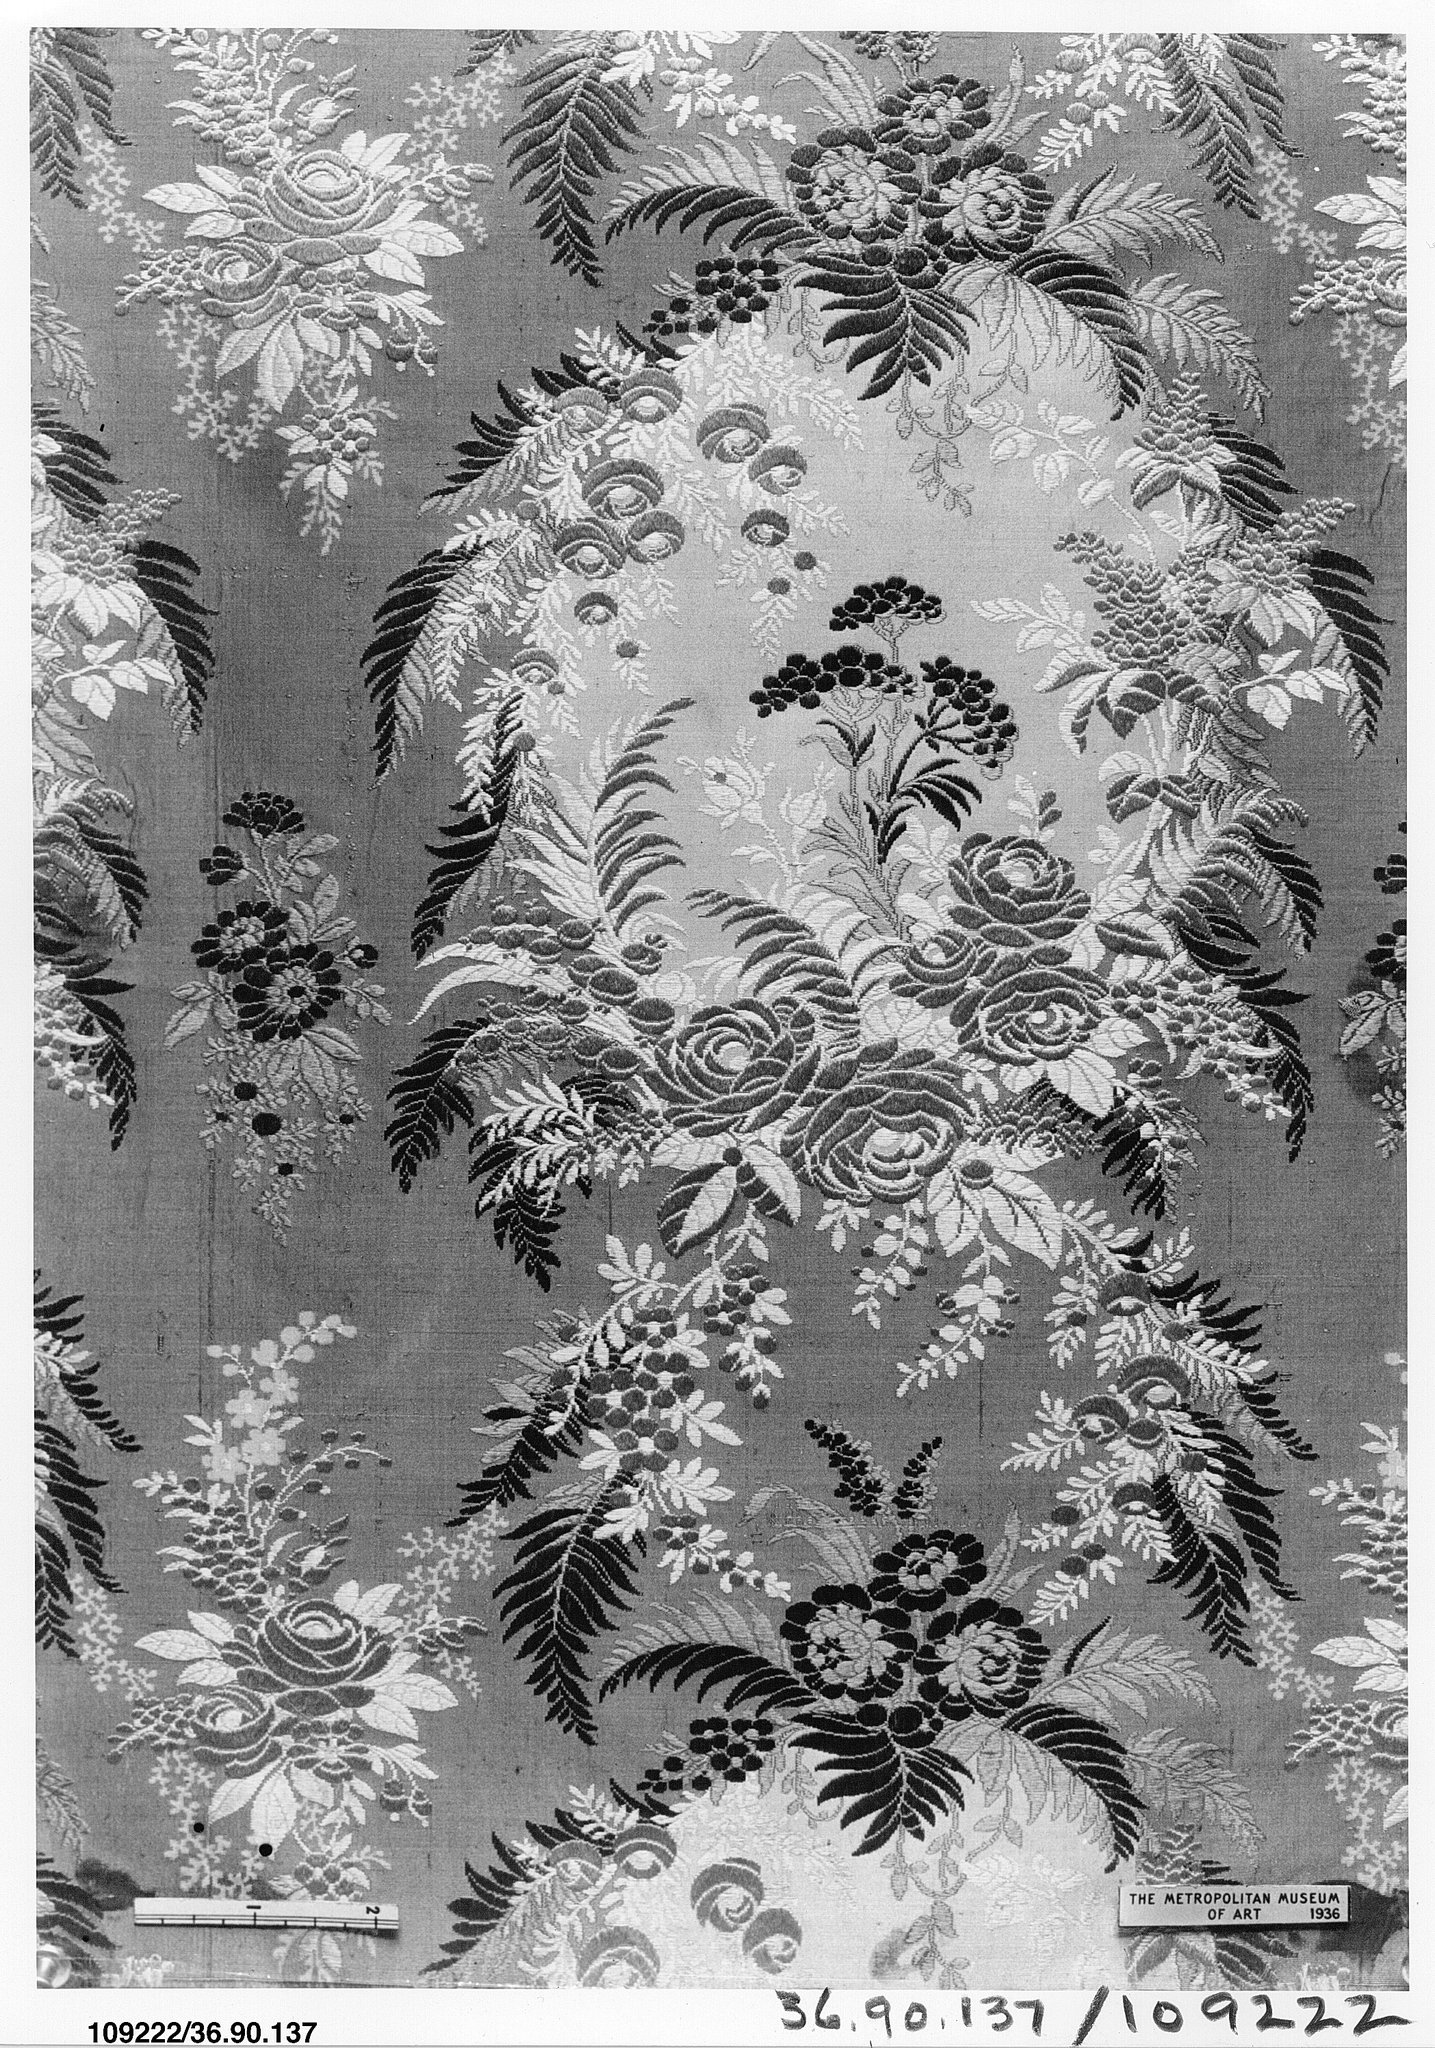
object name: piece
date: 1801-1900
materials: silk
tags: flowers,leaves